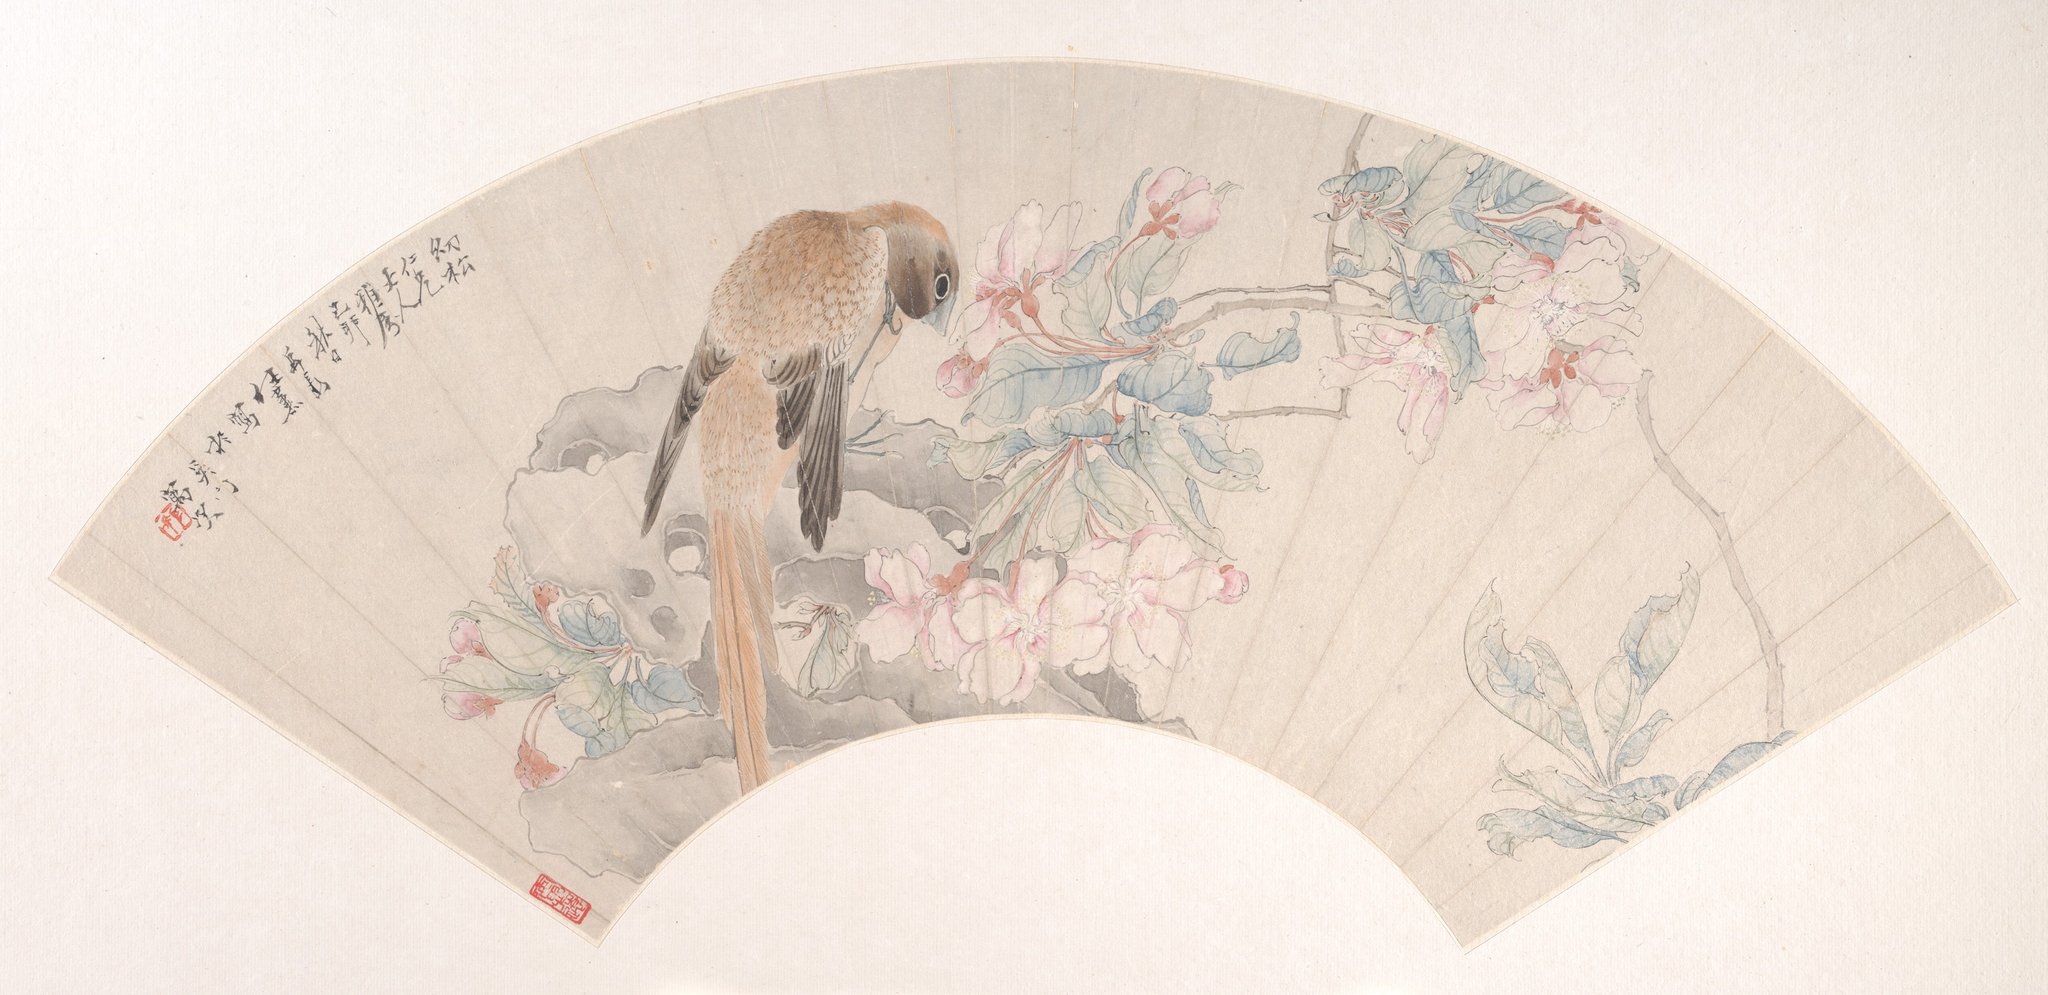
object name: folding fan mounted a an album leaf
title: Bird on a Rock by a Flowering Branch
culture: chinese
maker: ren xun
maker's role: artist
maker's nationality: chinese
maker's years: 1835-1893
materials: ink, paper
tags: birds,flowers